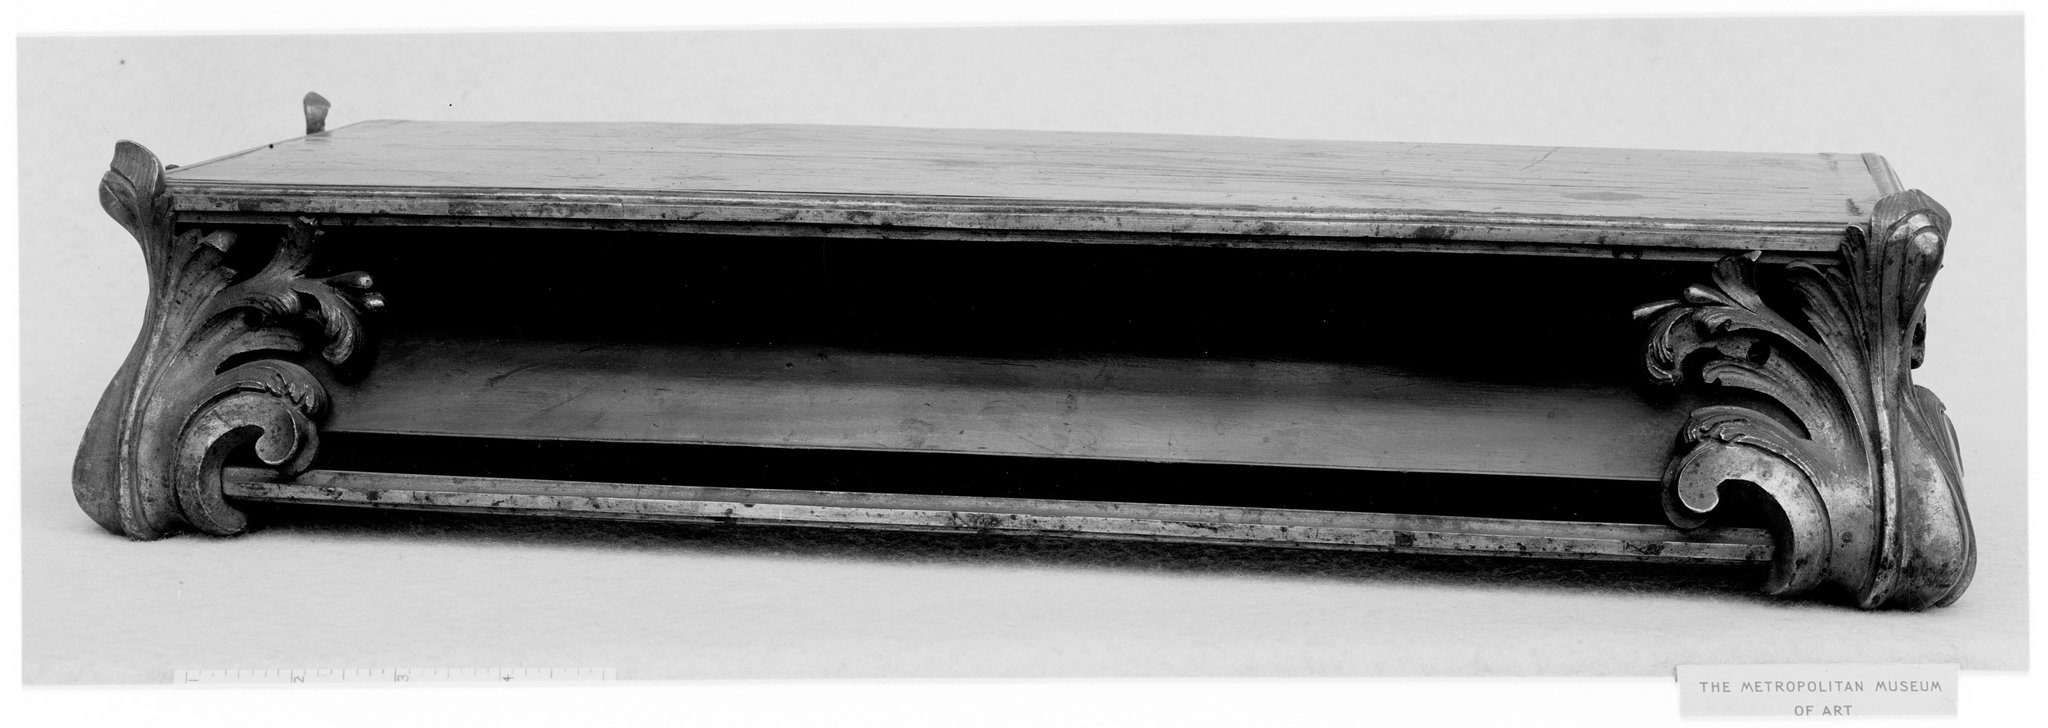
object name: pedestal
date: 1601-1800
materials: wood, gilt bronze